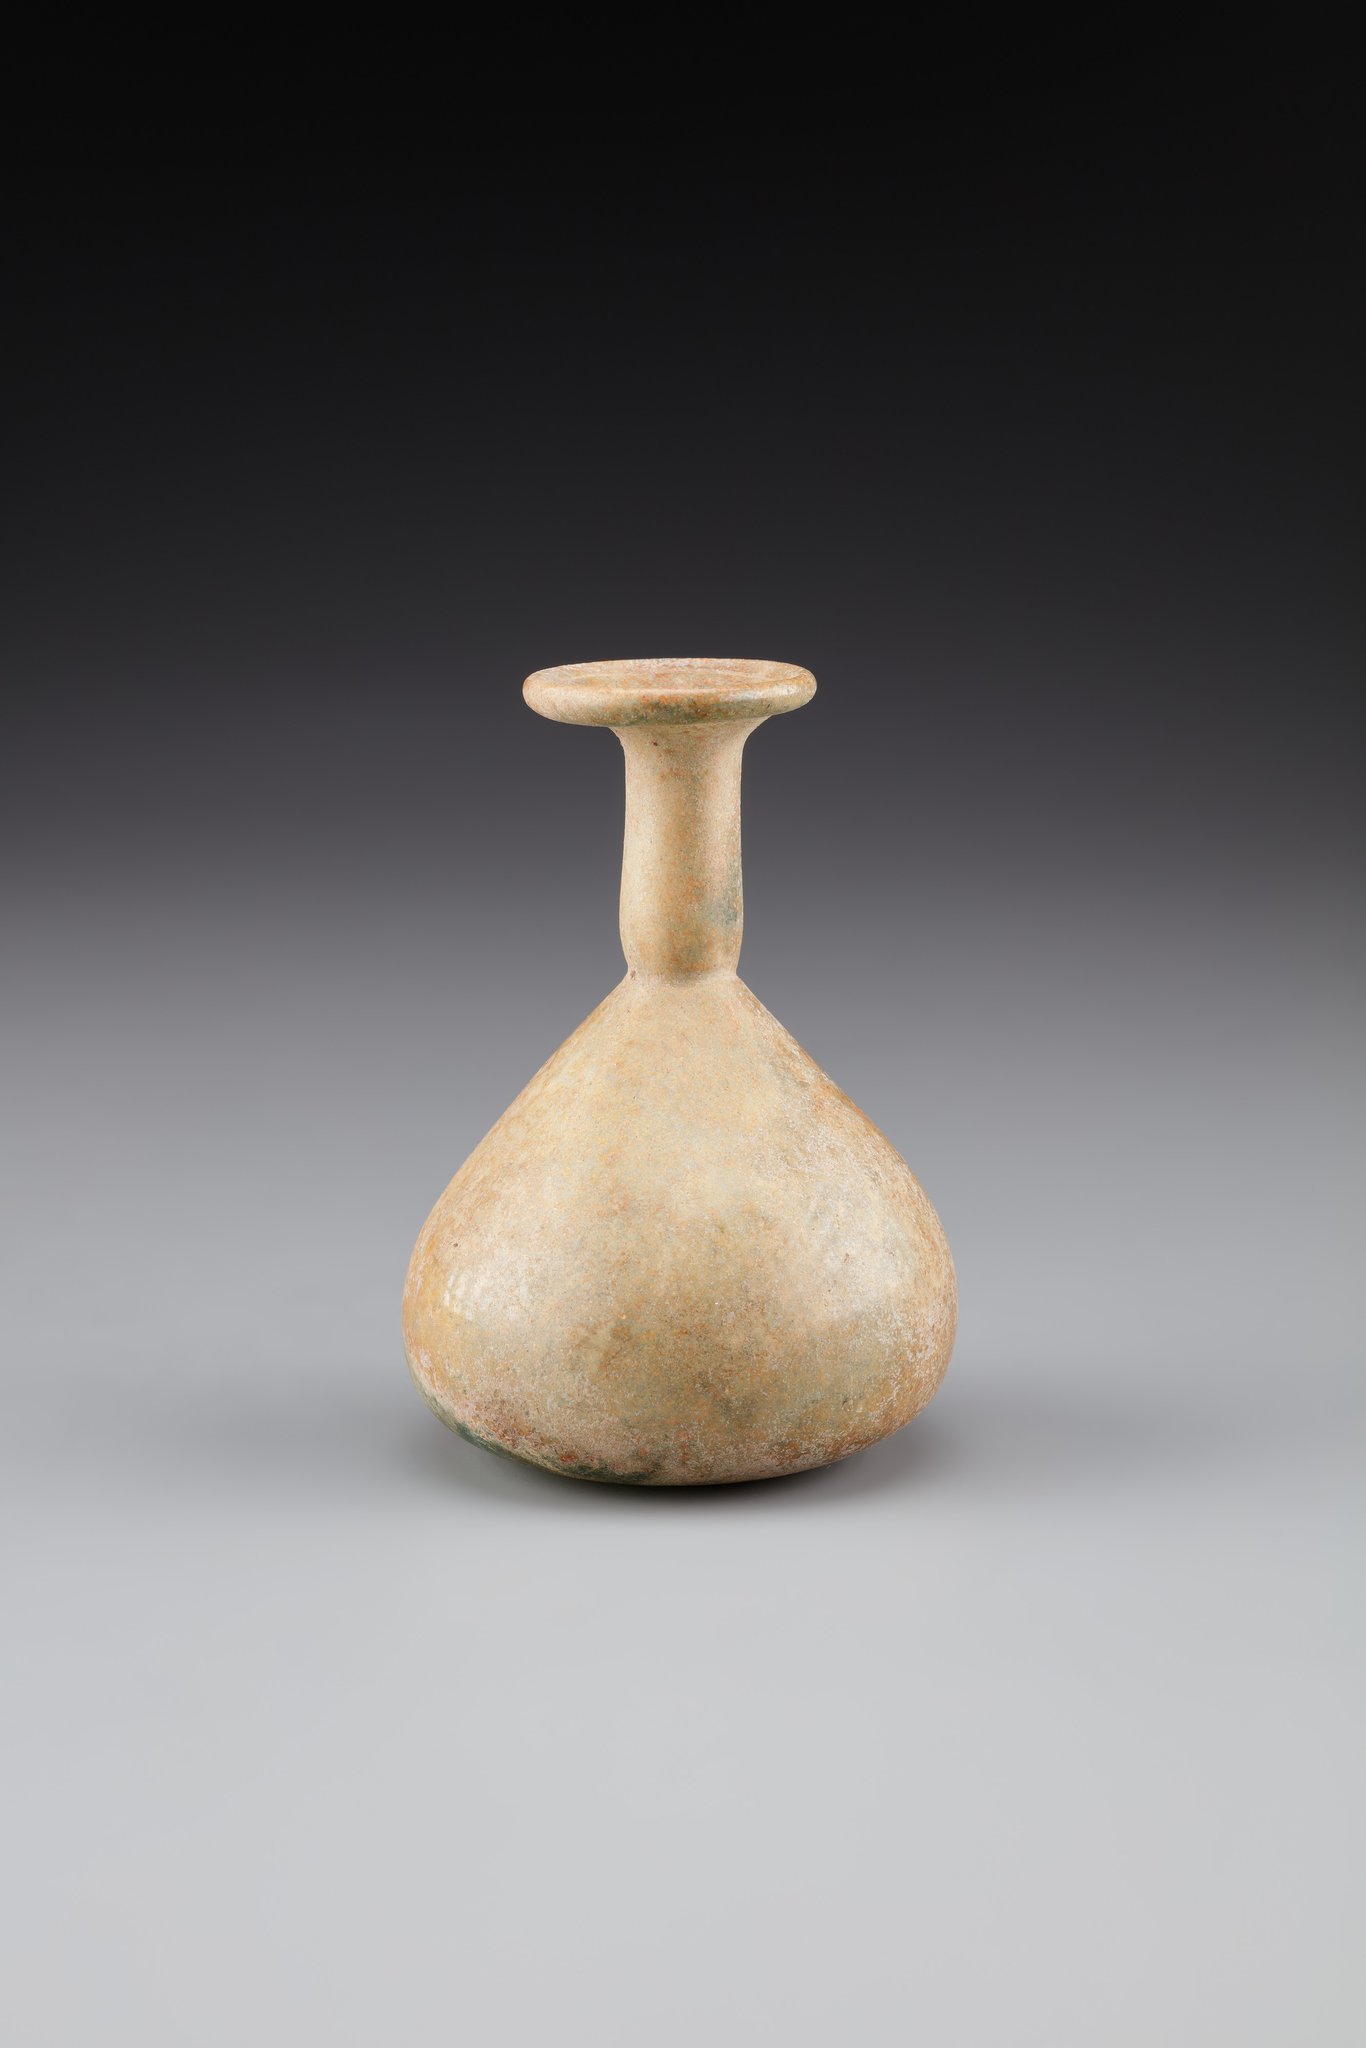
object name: vessel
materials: glass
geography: nubia